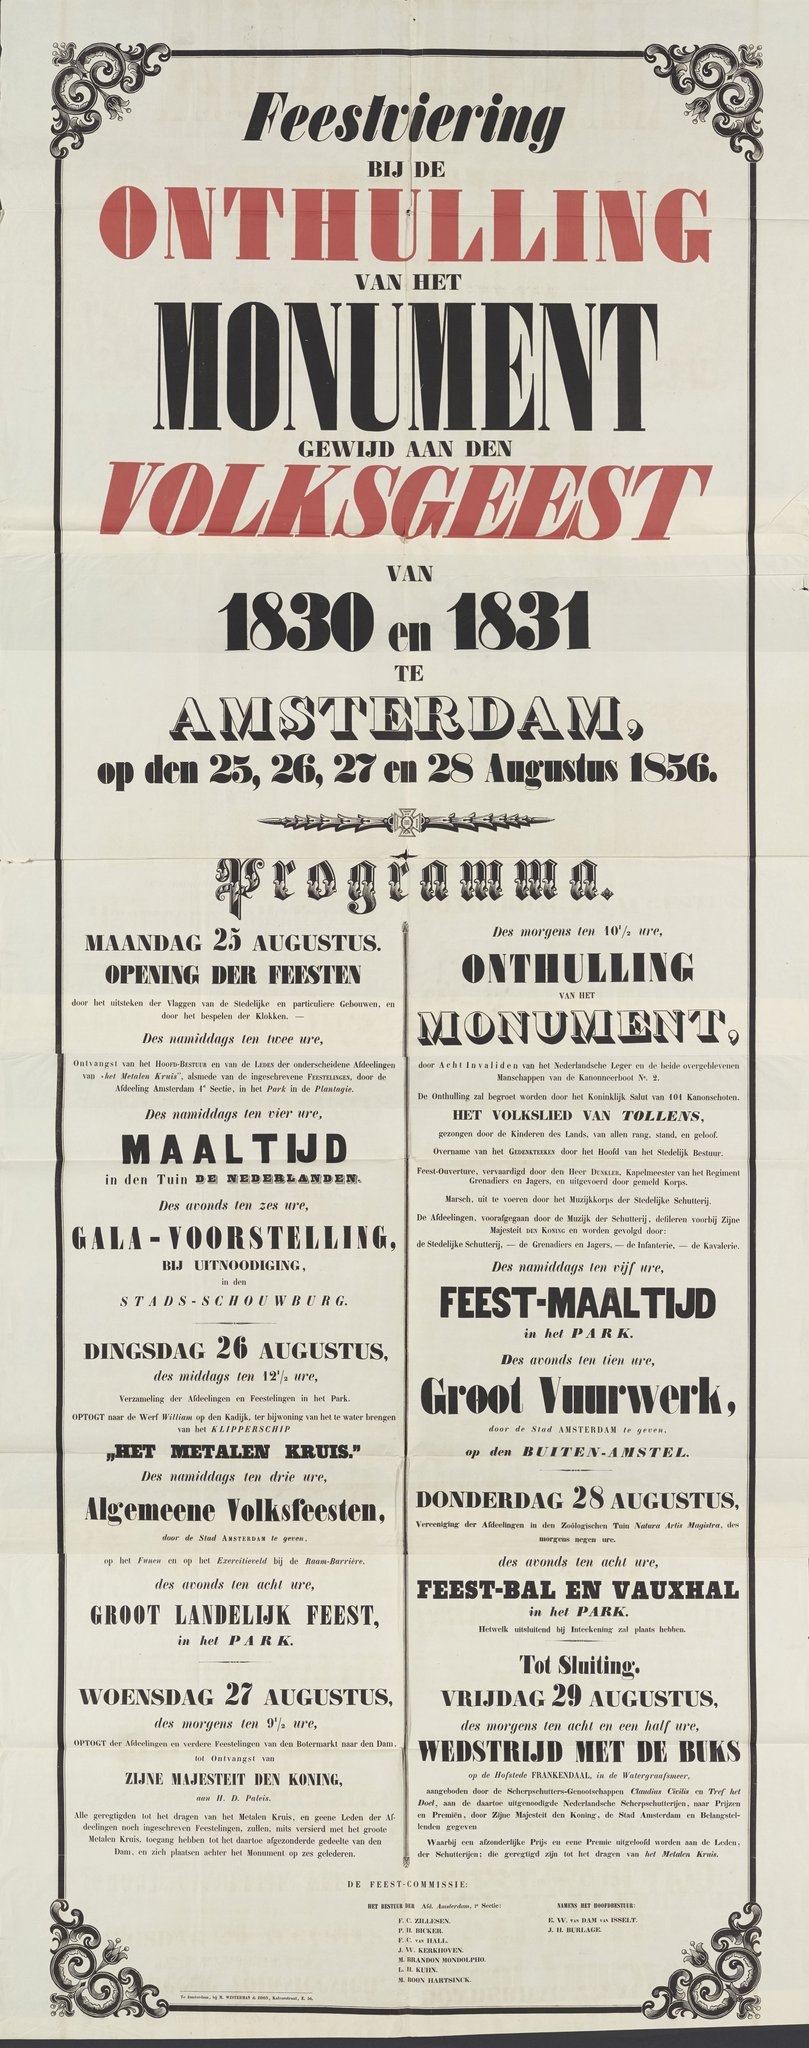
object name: poster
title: Feestviering bij de Onthulling van het Monument gewijd aan den volksgeest van 1830 en 1831 te Amsterdam op den 25, 26, 27 en 28 augustus 1856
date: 1856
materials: paper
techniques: letterpress printing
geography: amsterdam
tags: amsterdam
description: Aanplakbiljet voor de feesten van 25-28 augustus 1856, rondom de onthulling van het Monument gewijd aan de volksgeest van 1830 en 1831, ook bekend als Naatje op de Dam, te Amsterdam.